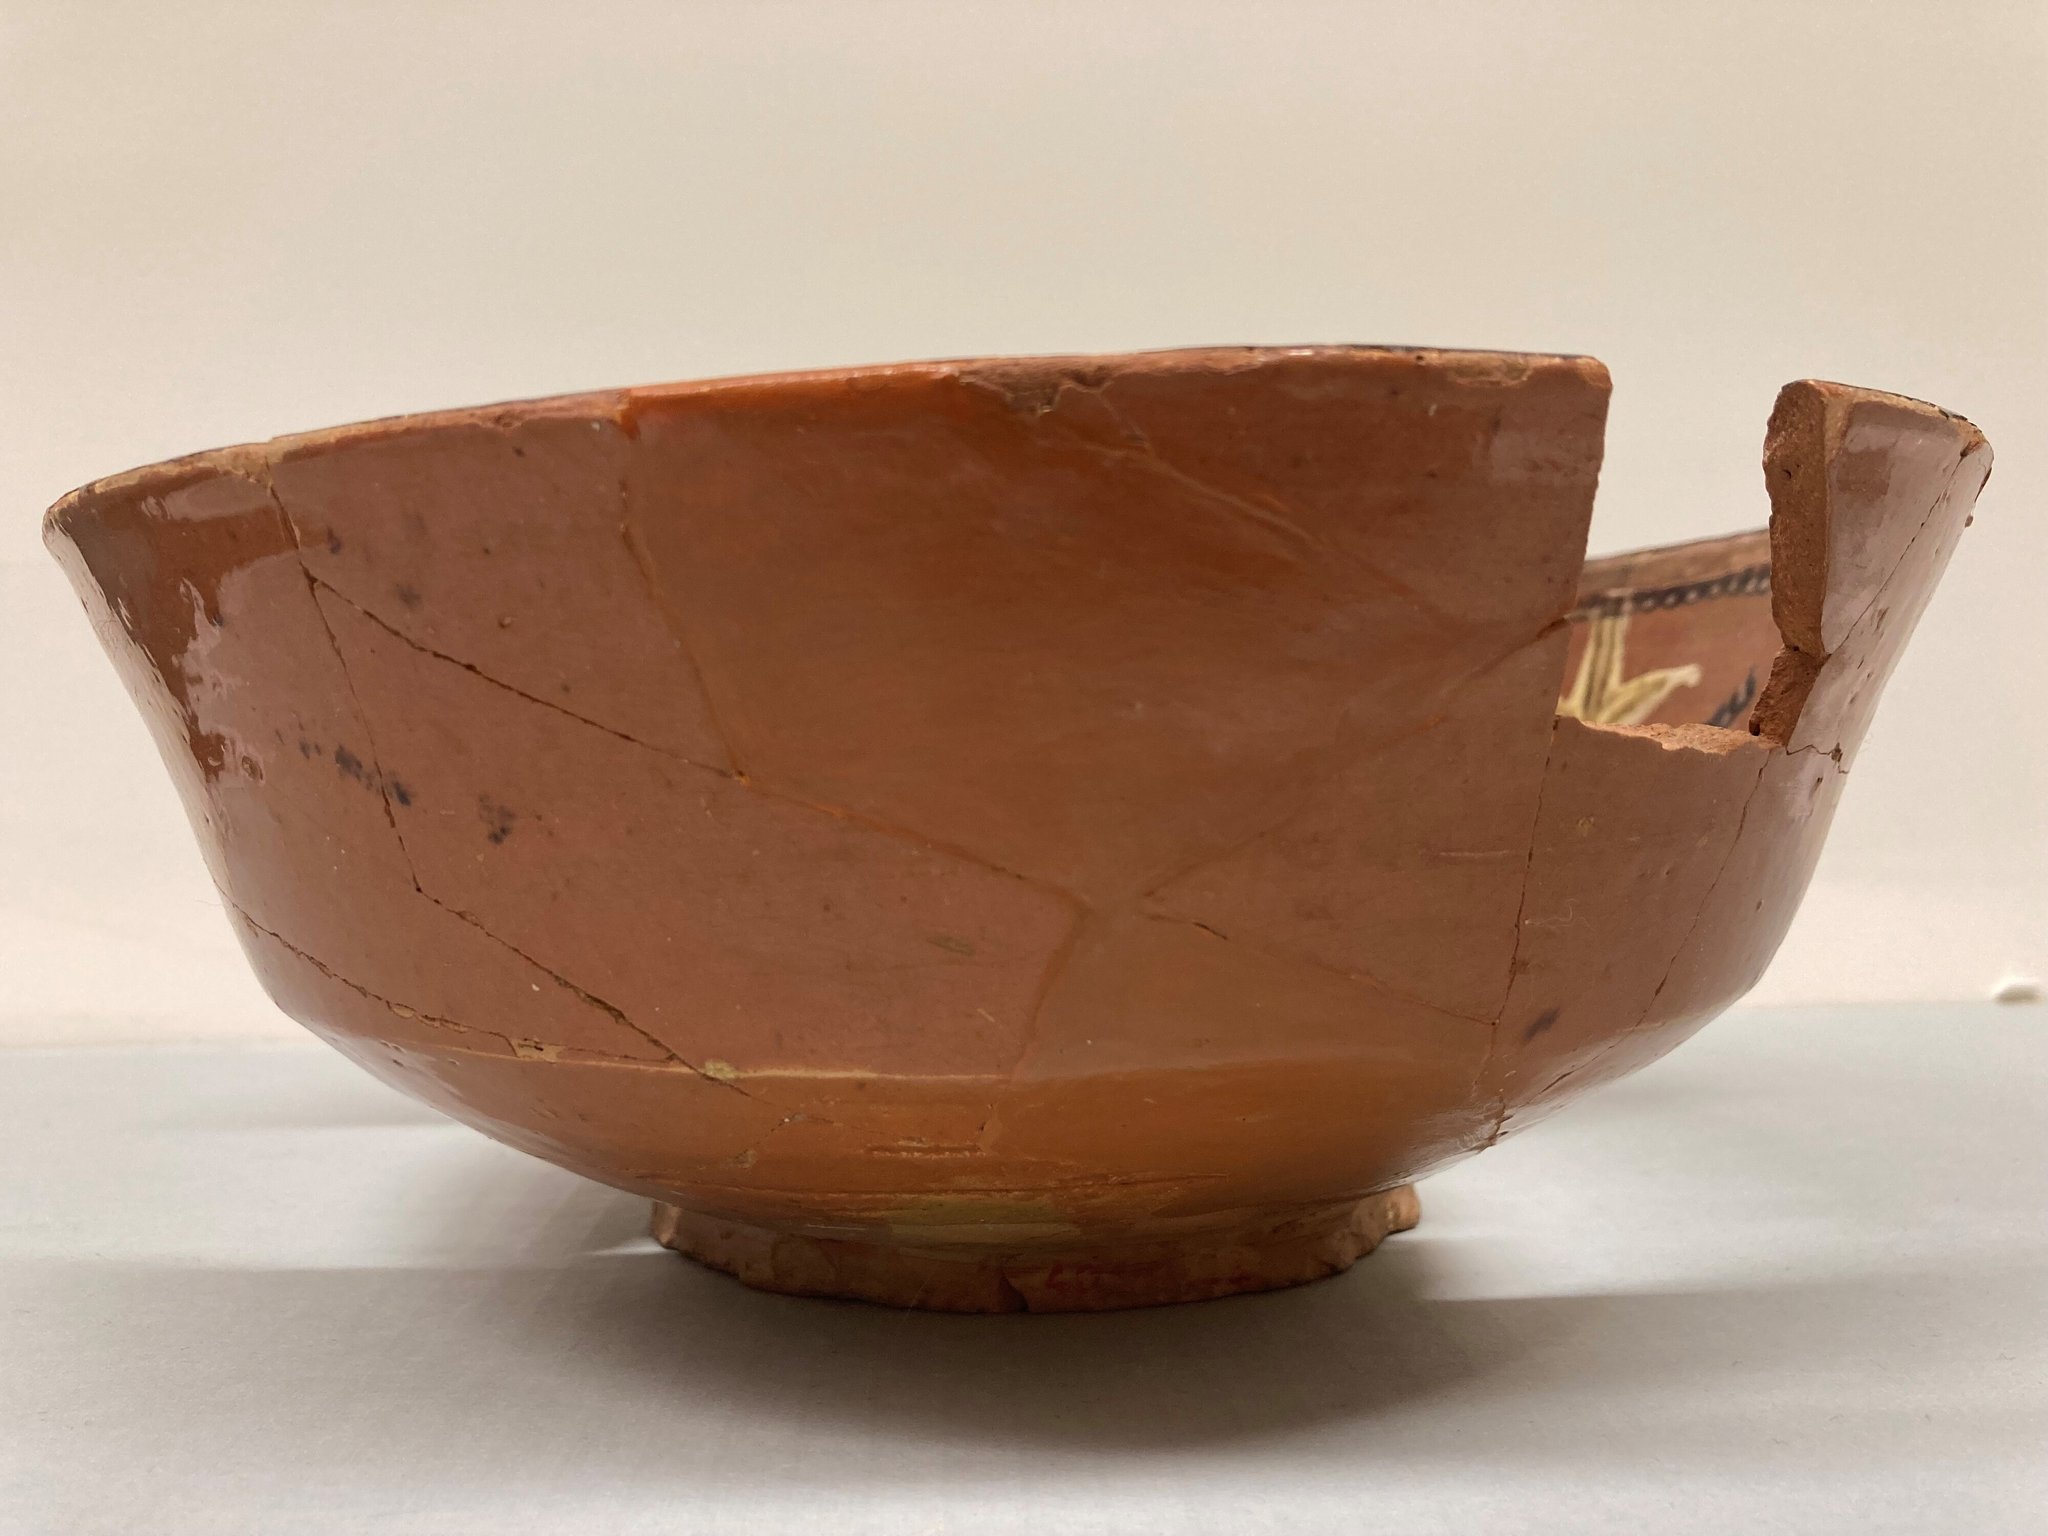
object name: bowl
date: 901-1000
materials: earthenware, glaze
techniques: polychrome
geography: iran